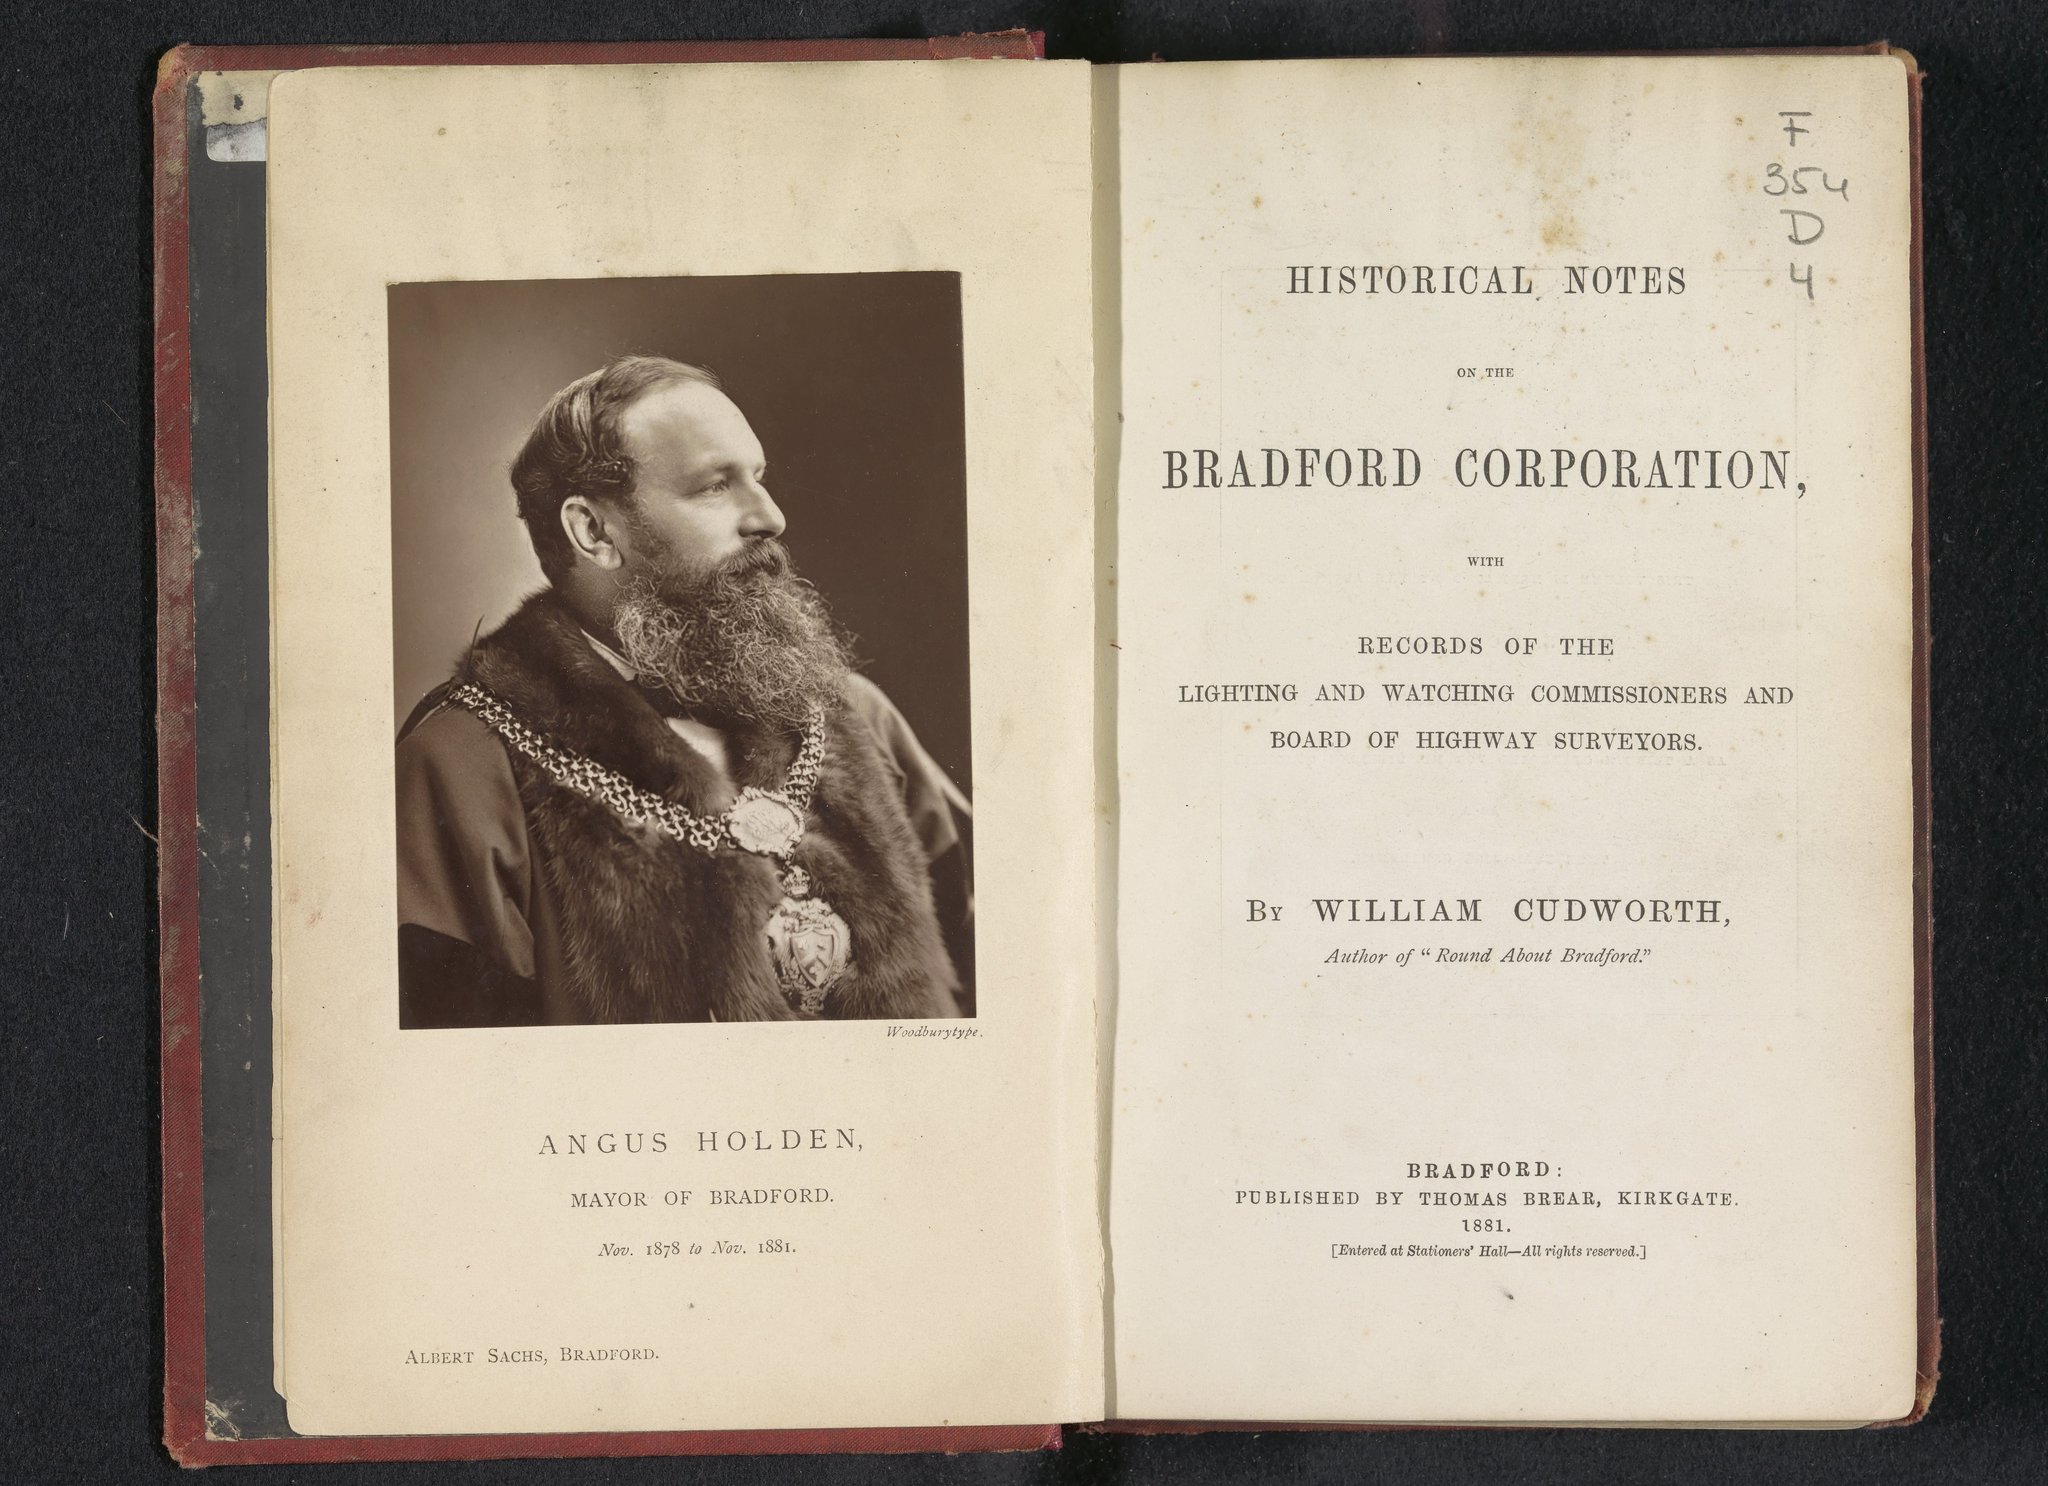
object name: page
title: Angus Holden, mayor of Bradford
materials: paper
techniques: woodburytype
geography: bradford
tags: historical persons (portraits and scenes from the life) (+ (full) bust portrait)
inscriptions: inscription: ‘Nov. 1878 to Nov. 1881.’